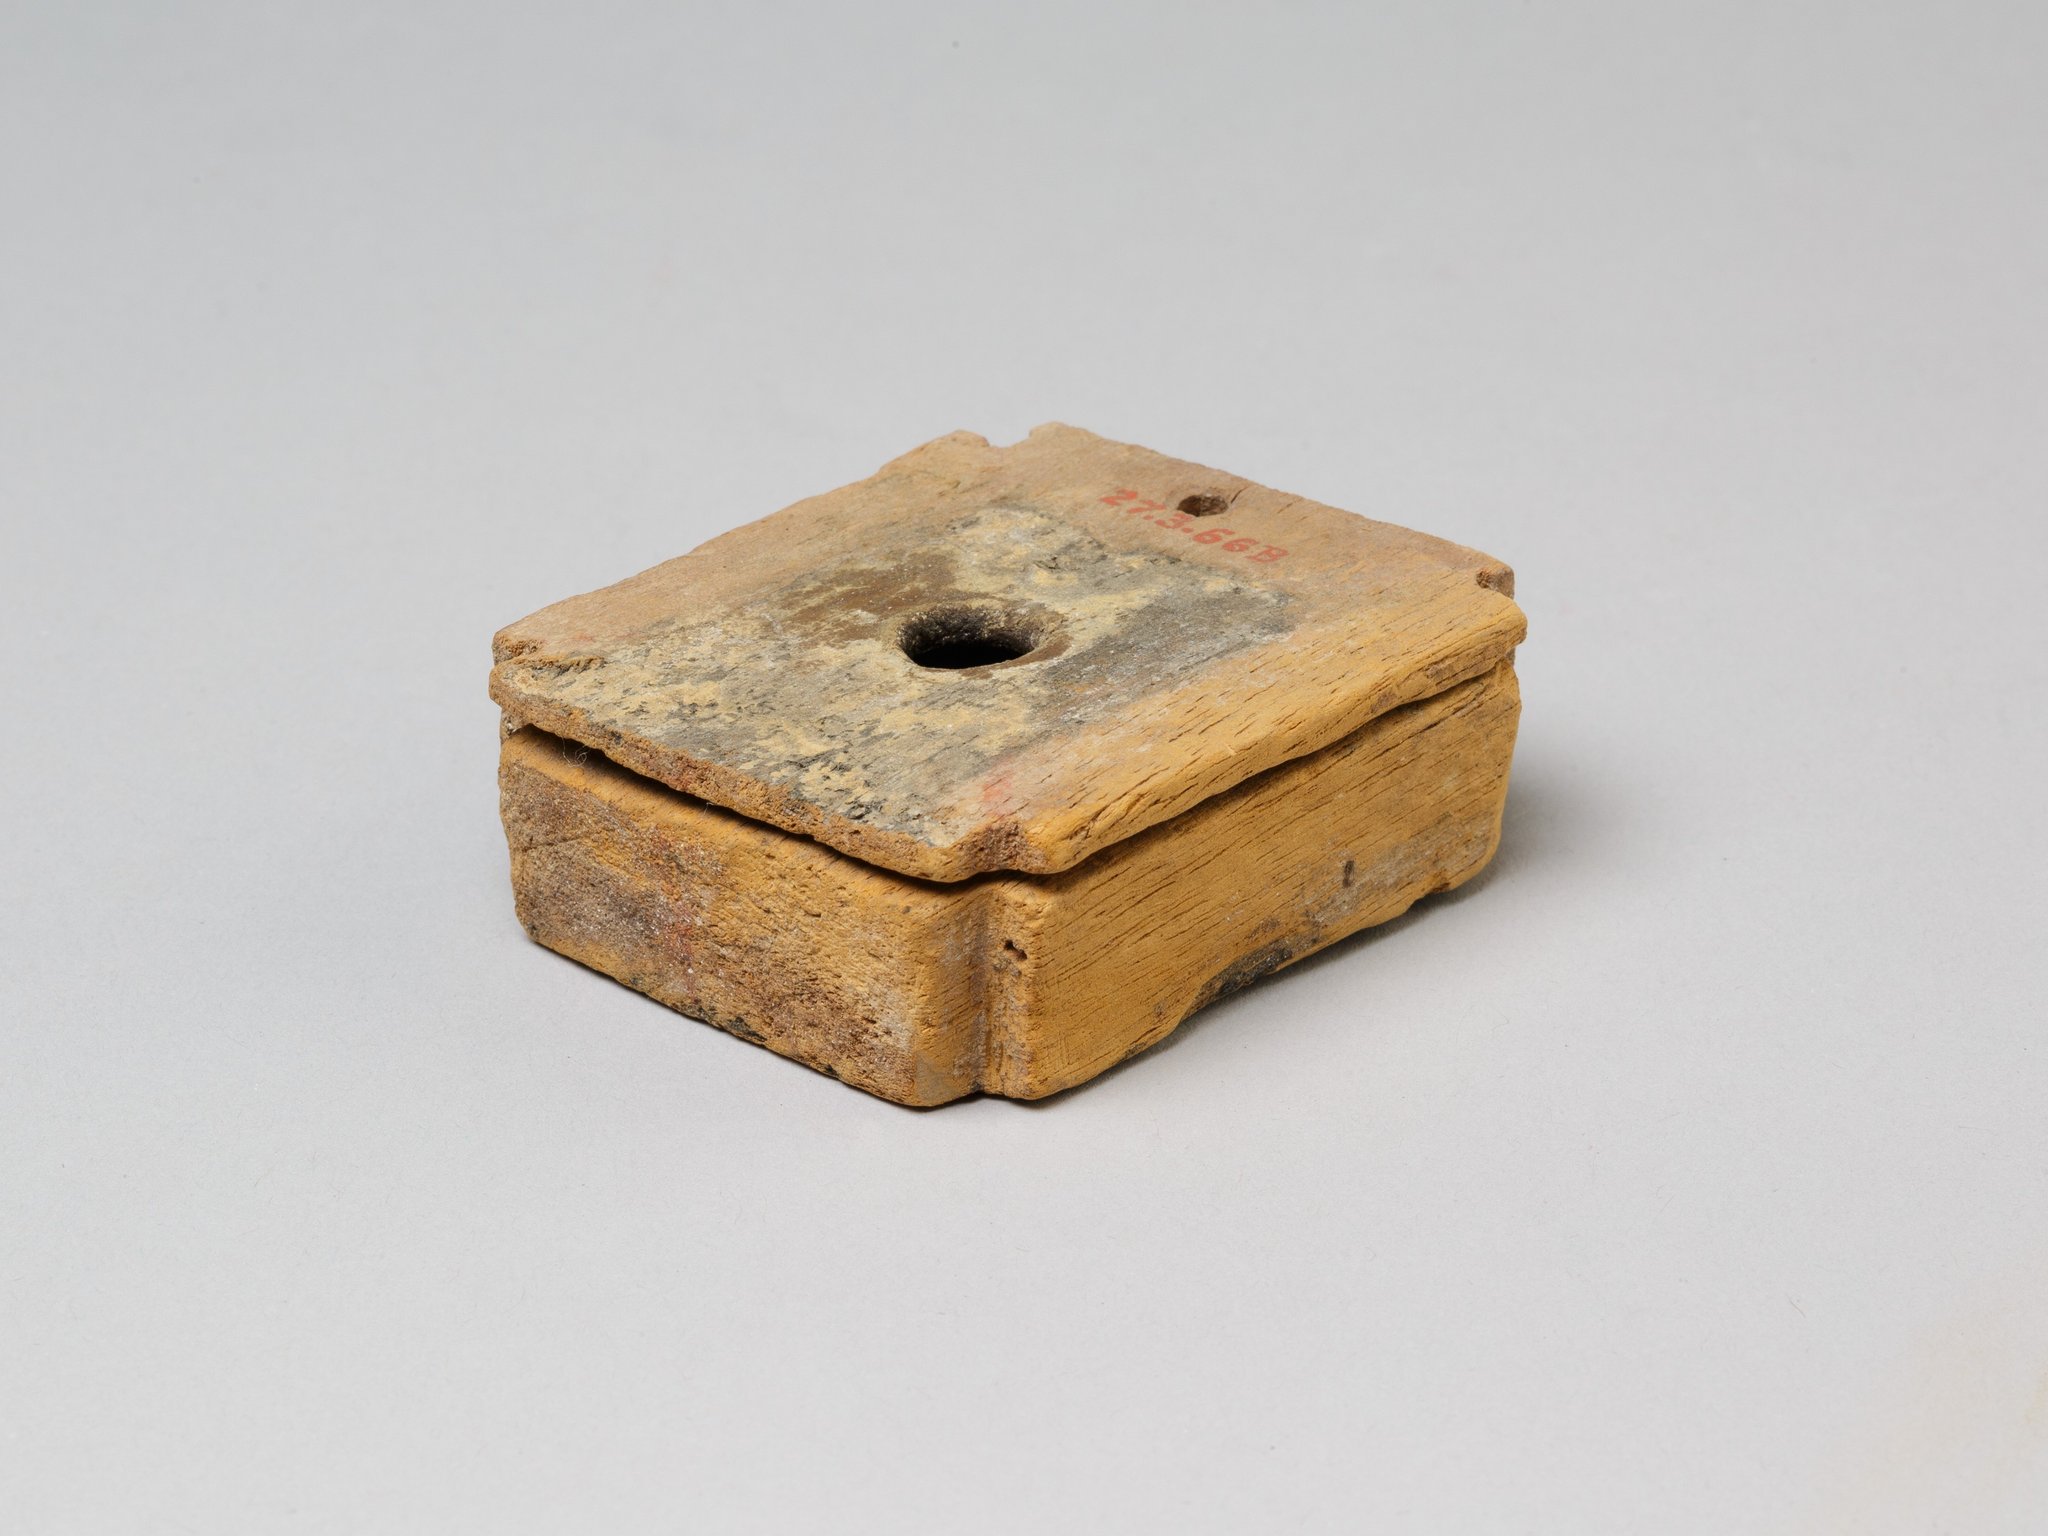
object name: inkwell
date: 2124-1504 BCE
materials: wood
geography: egypt